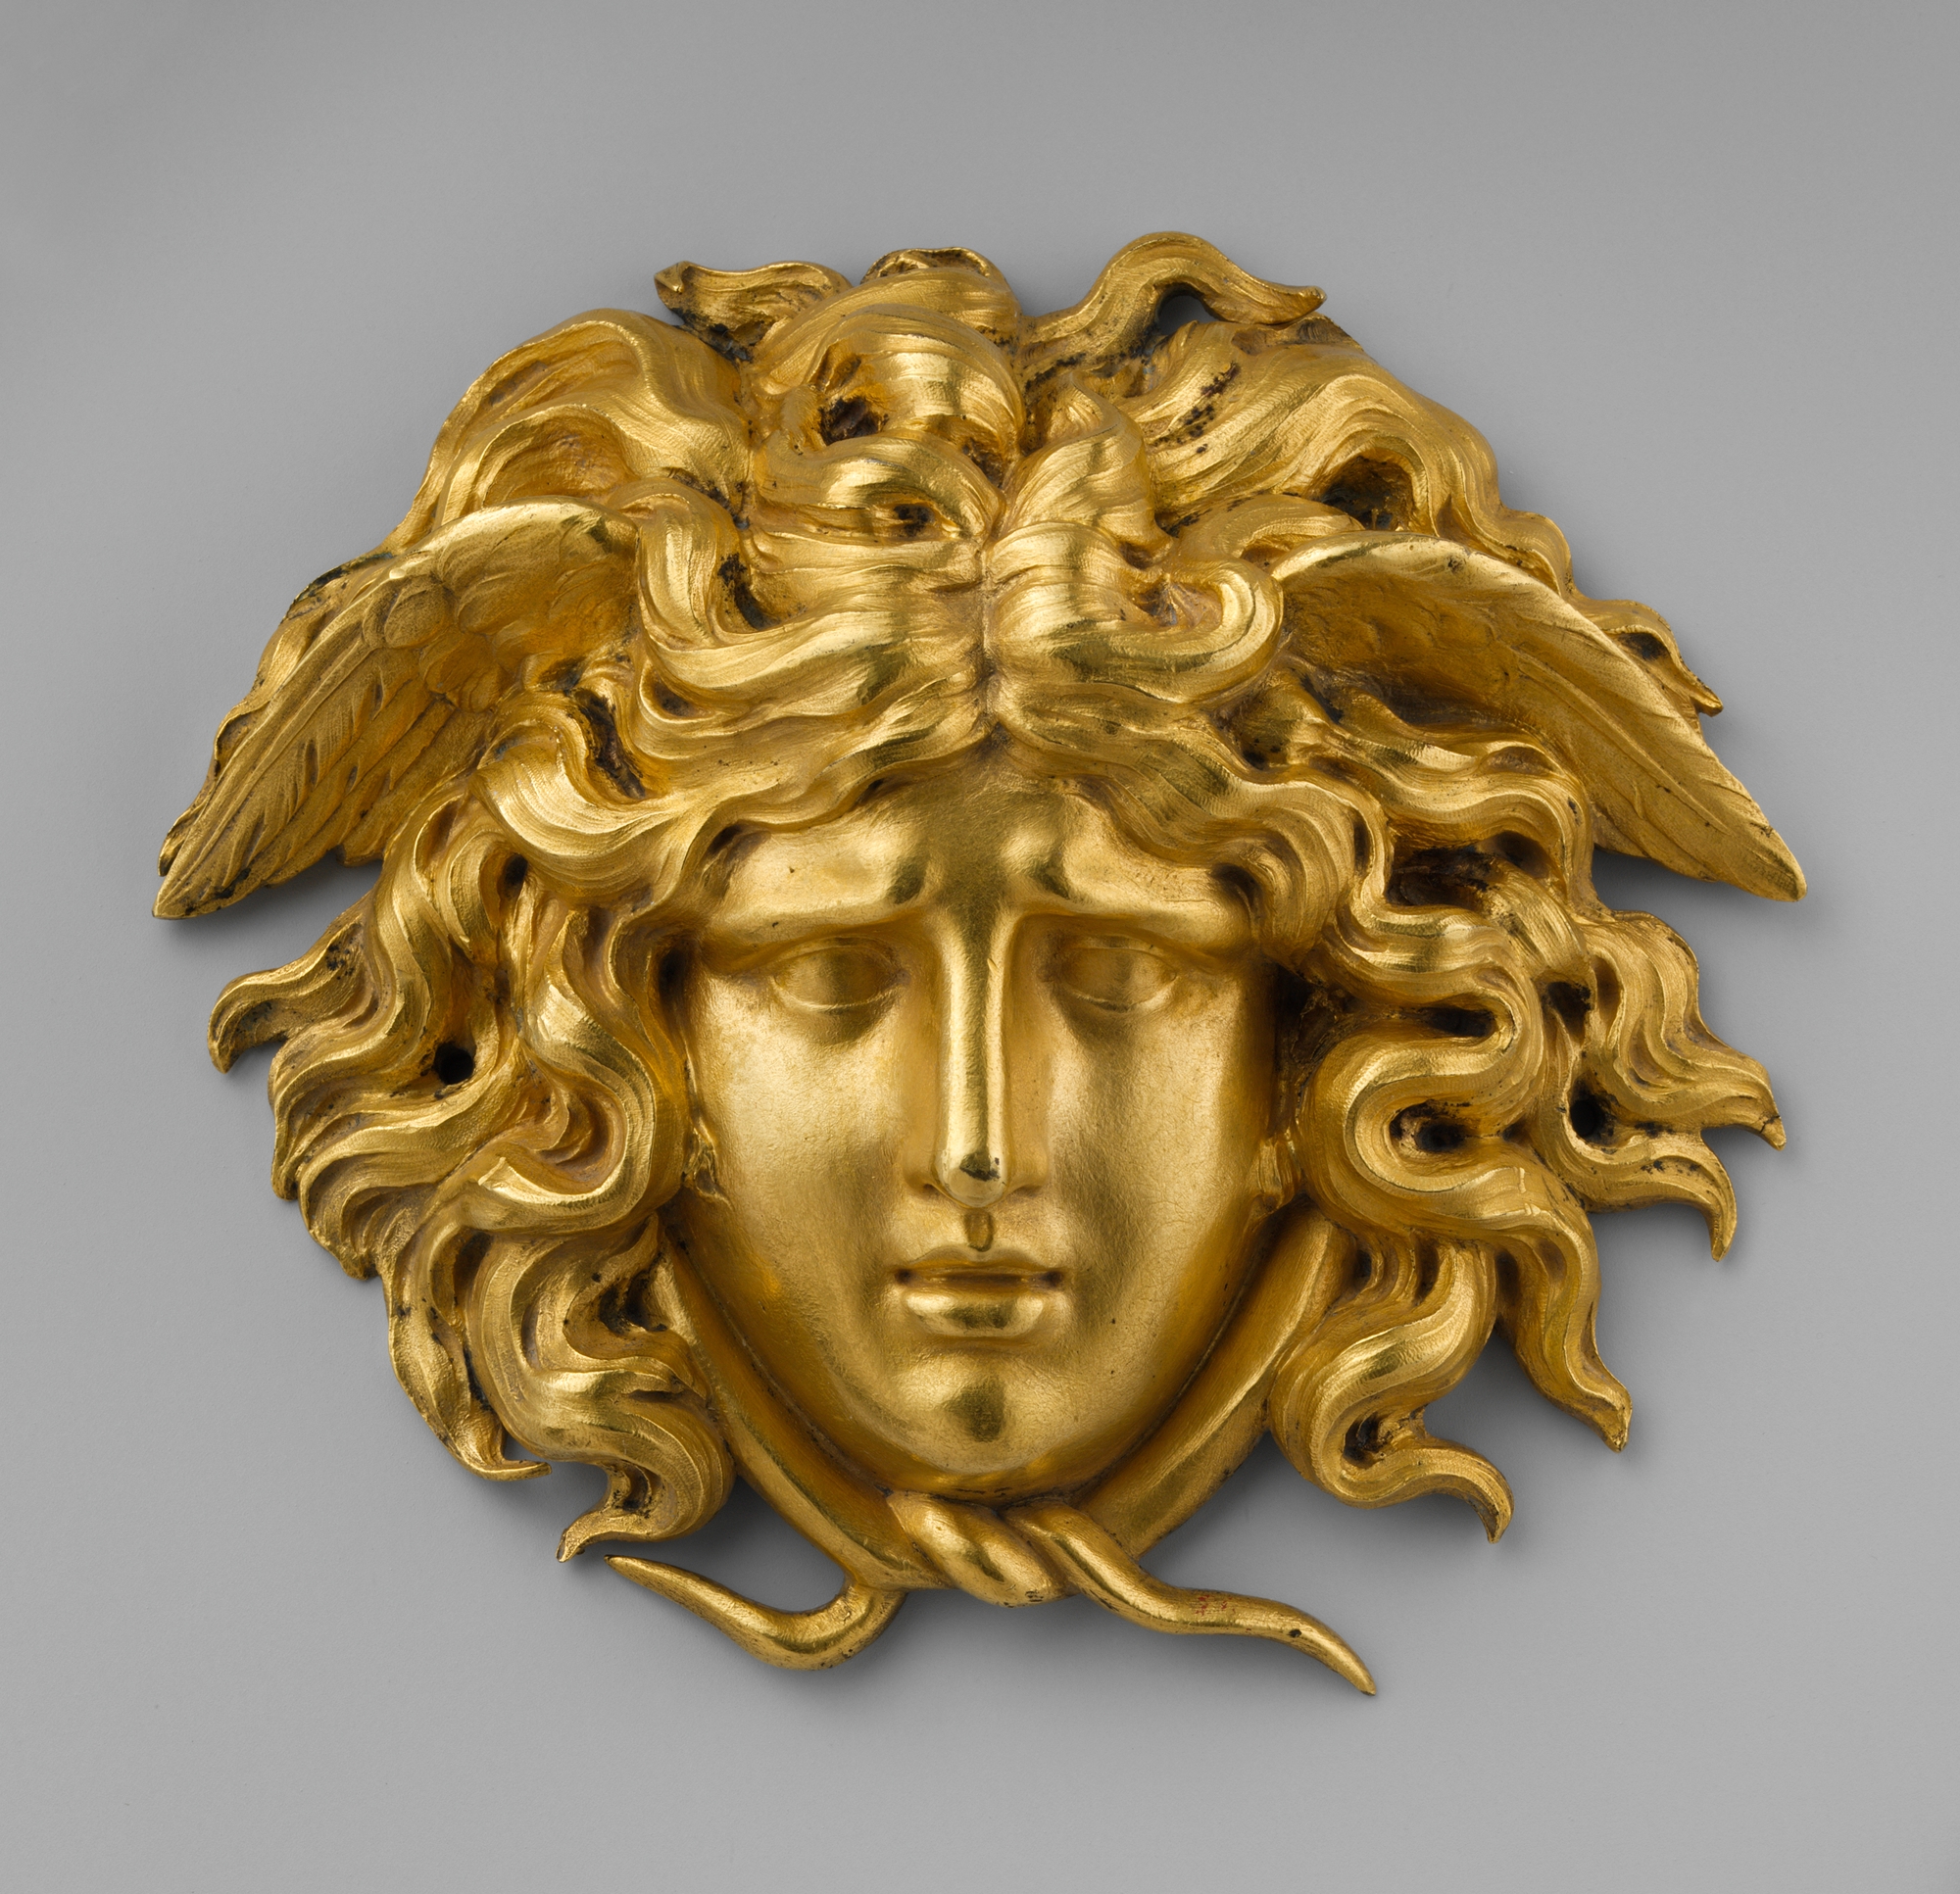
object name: mask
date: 1767-1833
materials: gilt bronze